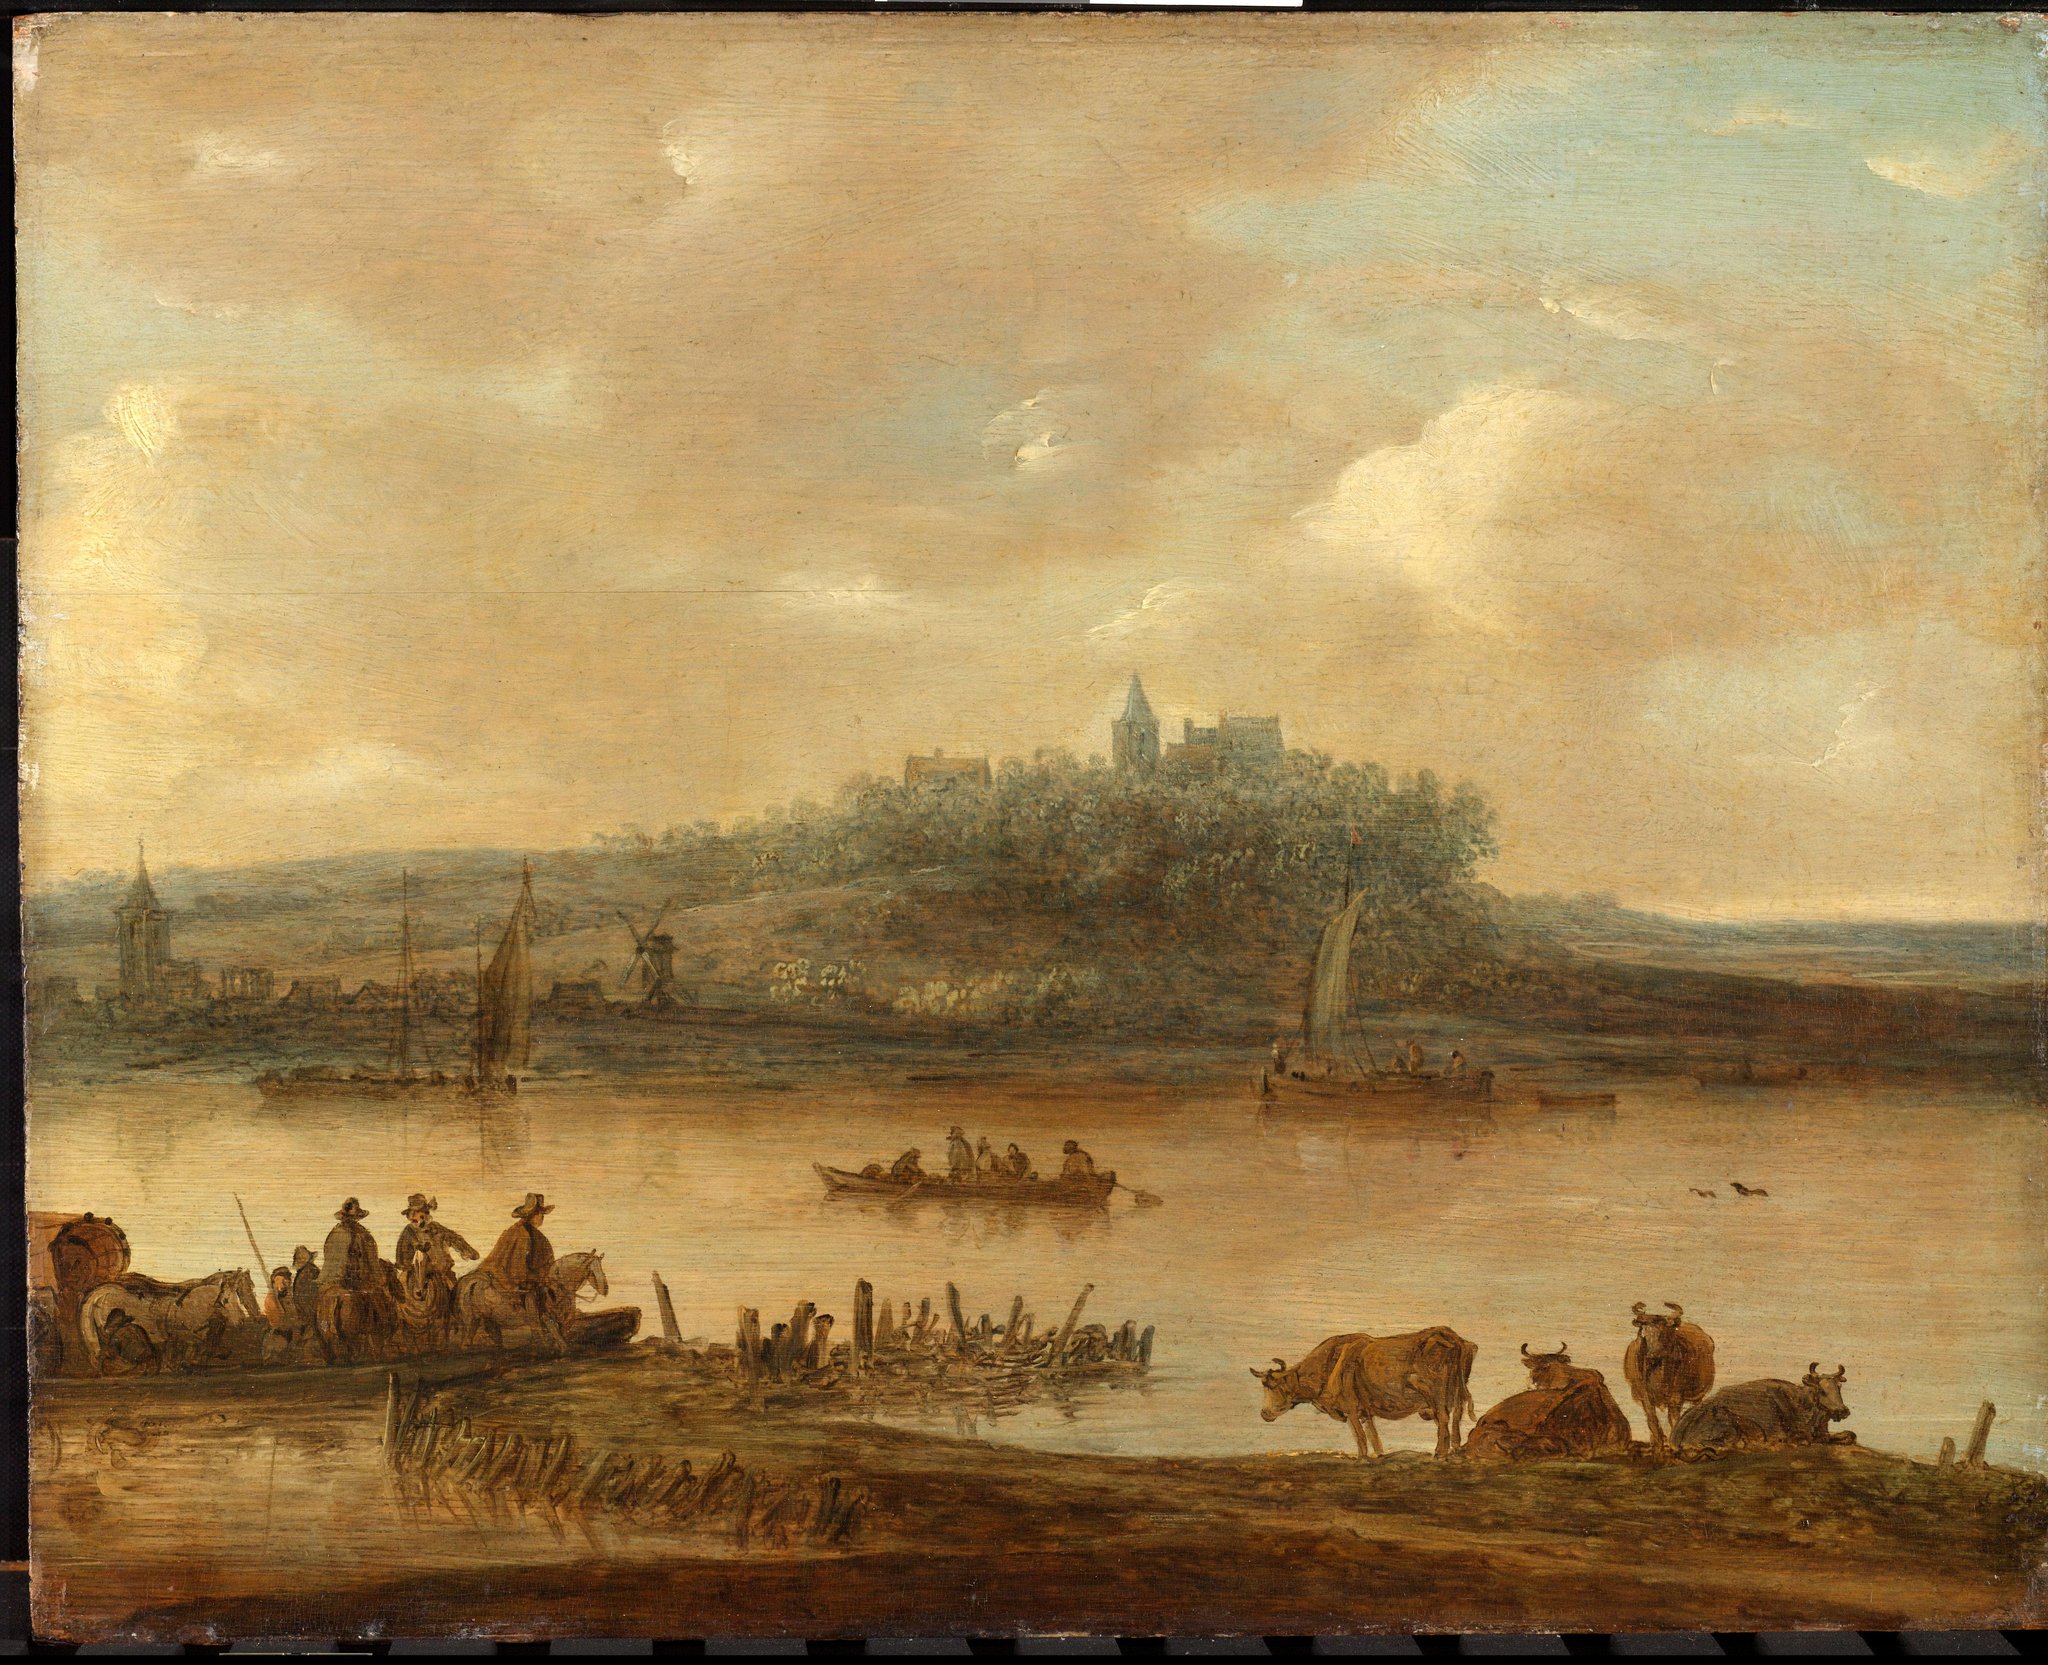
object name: painting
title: View of the Rhine and the Elterberg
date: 1645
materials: oil, panel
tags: ferry, river (+ landscape with figures, staffage)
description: Gezicht op de Rijn en de Elterberg. Op het water een veerpont en enkele andere vaartuigen, op de oever op de voorgrond enkele koeien.